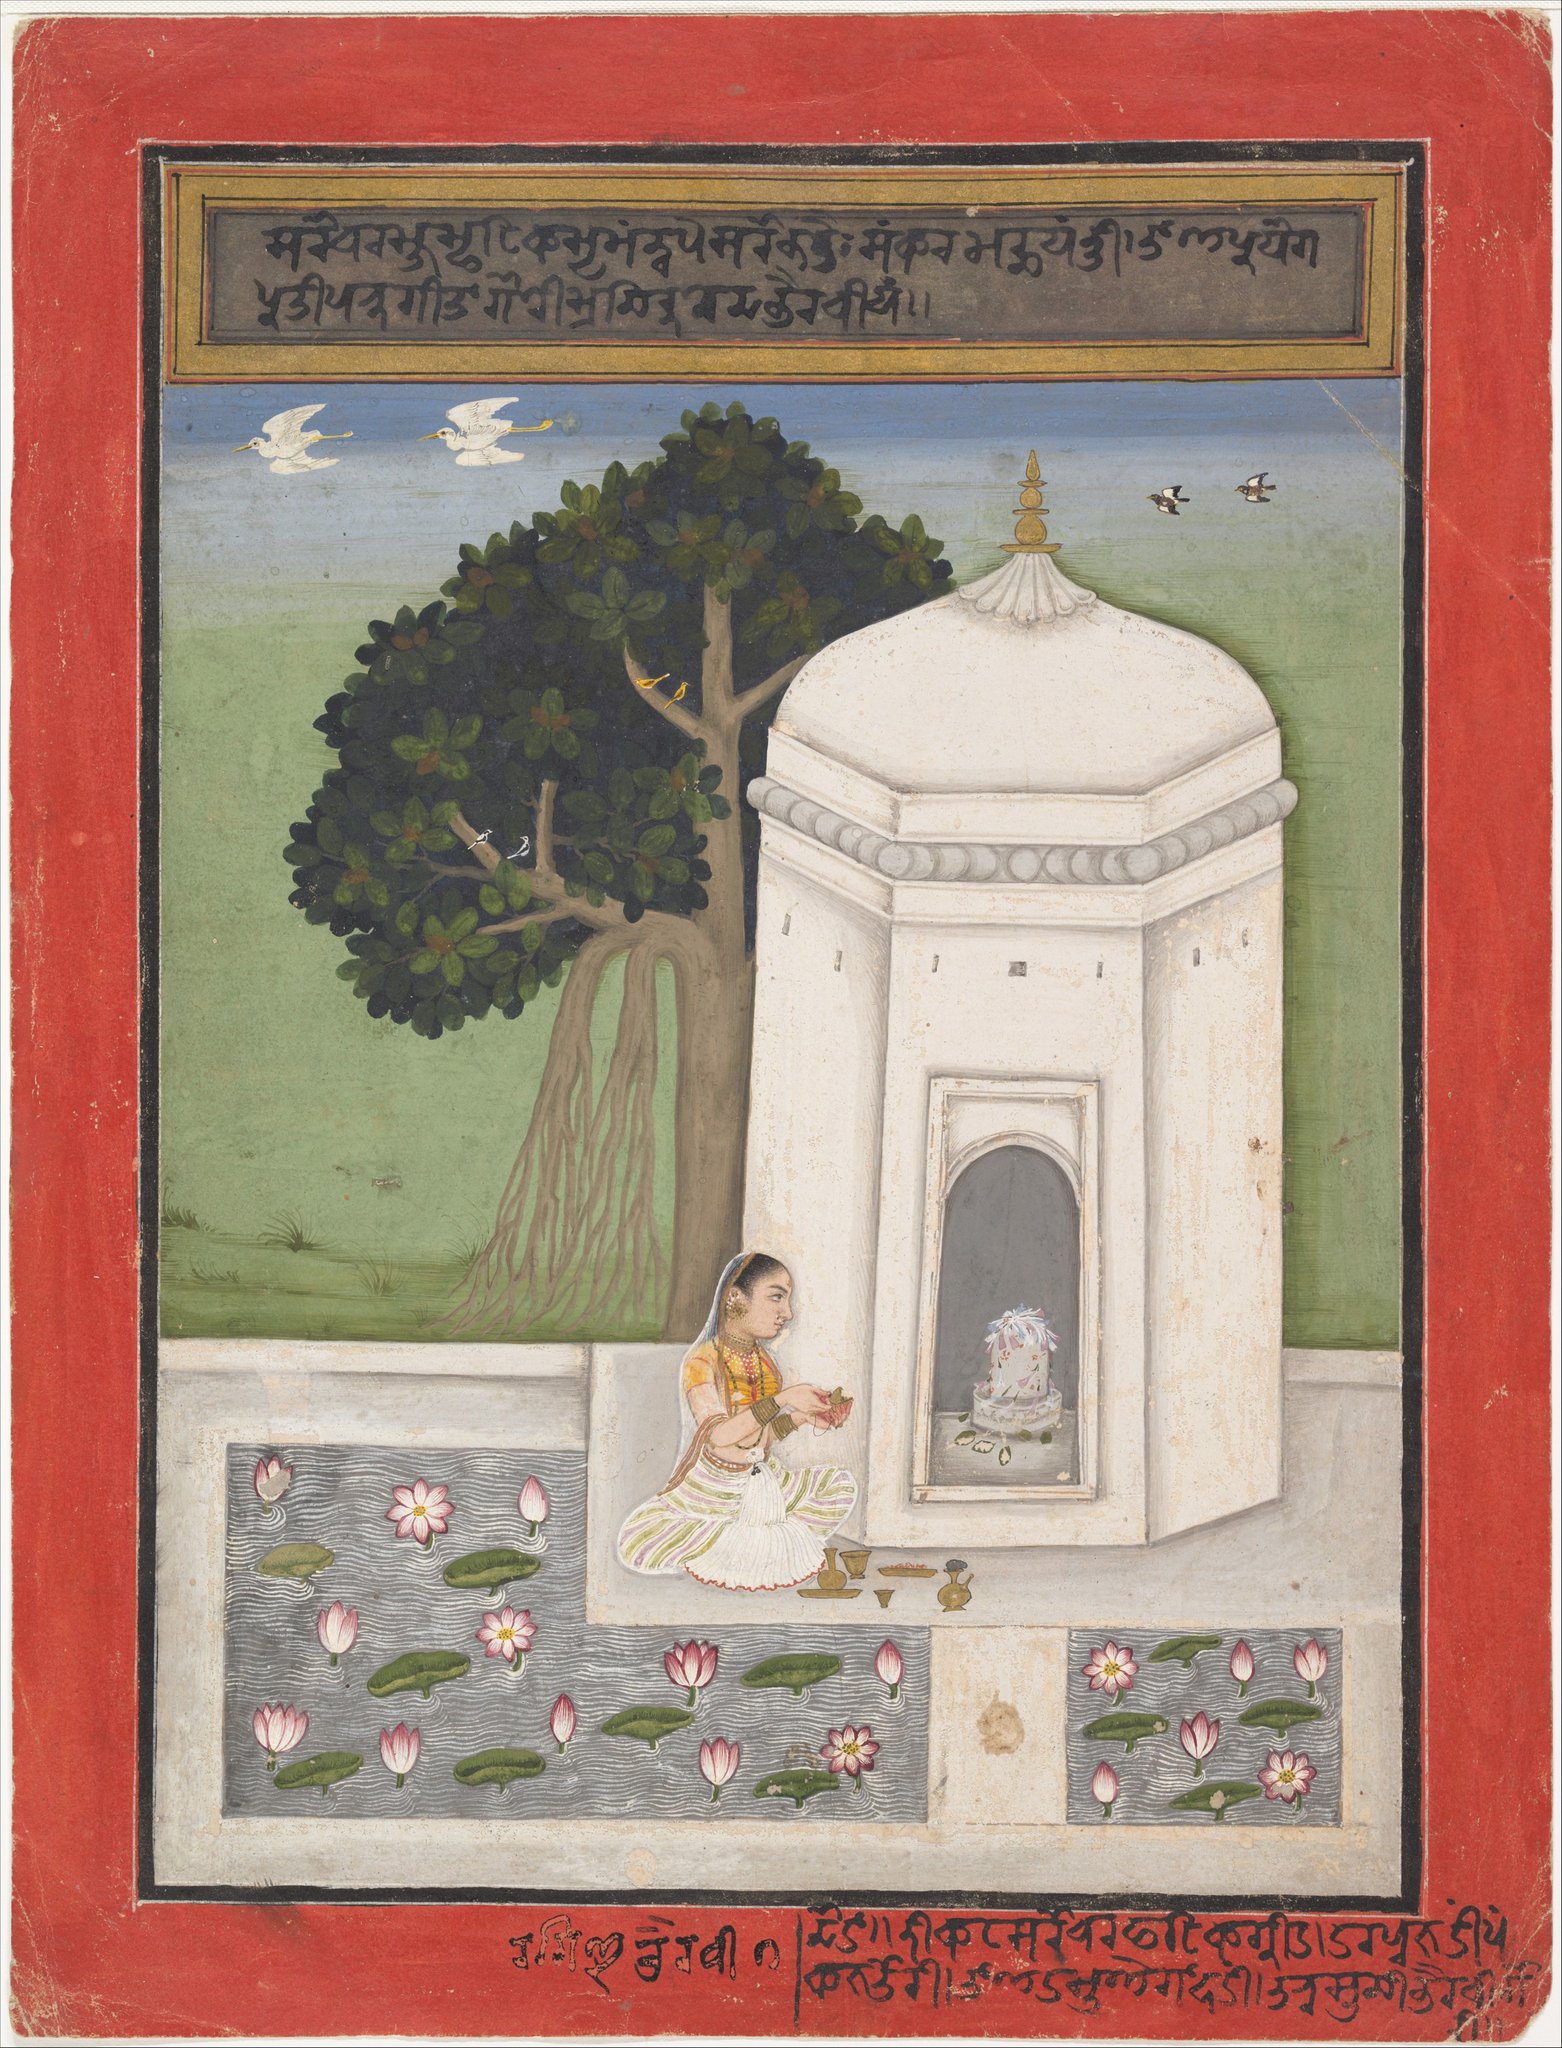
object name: folio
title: Bhairavi Ragini: Folio from a ragamala series (Garland of Musical Modes)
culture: indian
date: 1640-1650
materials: gold, ink, paper, silver, watercolor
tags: women,lotuses,trees